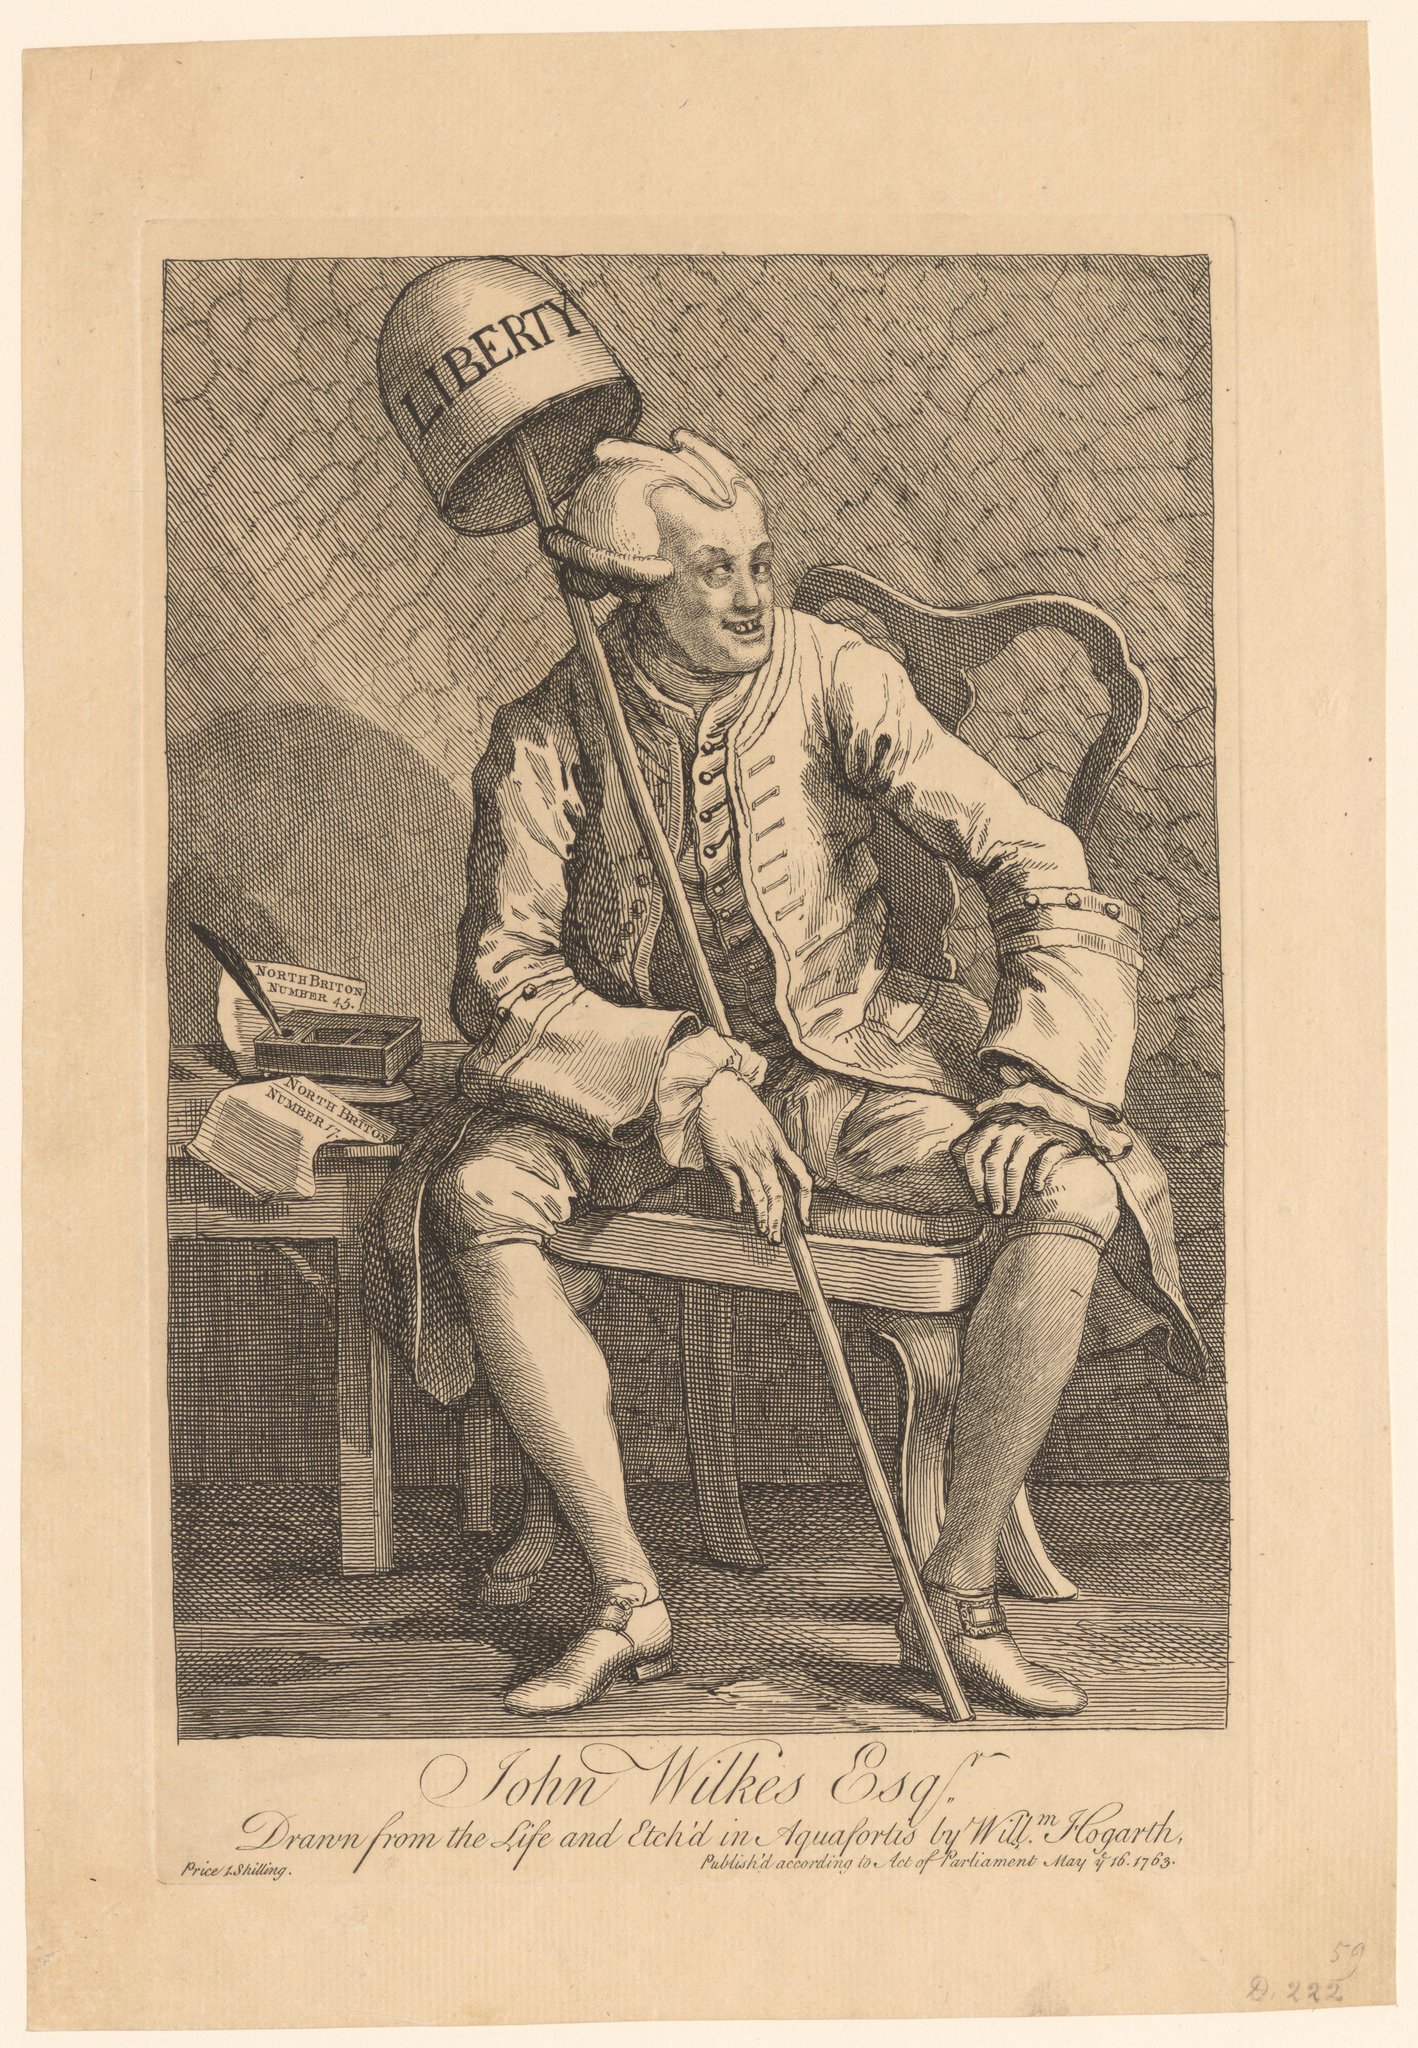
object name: print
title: Portret van John Wilkes Esqr.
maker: william hogarth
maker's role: draughtsman, painter, print maker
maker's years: 1697-1764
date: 1763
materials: paper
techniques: engraving, etching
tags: london, historical persons, politician, e.g. party leader, political caricatures and satires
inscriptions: collector's mark: Lugt 2228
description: Tekst in het Engels in de ondermarge, op de kap en op de tekstbladen. De schets is mogelijk gemaakt tijdens de rechtszaak tegen Wilkes die was aangeklaagd wegens zijn commentaar op het regeren van koning George III in de 45e editie van de krant The North Briton. De hoed met 'Liberty' (gelijkend een pileus, of vrijheidshoed) wordt op een stok hooggehouden. Op tafel liggen twee edities van The North Briton.